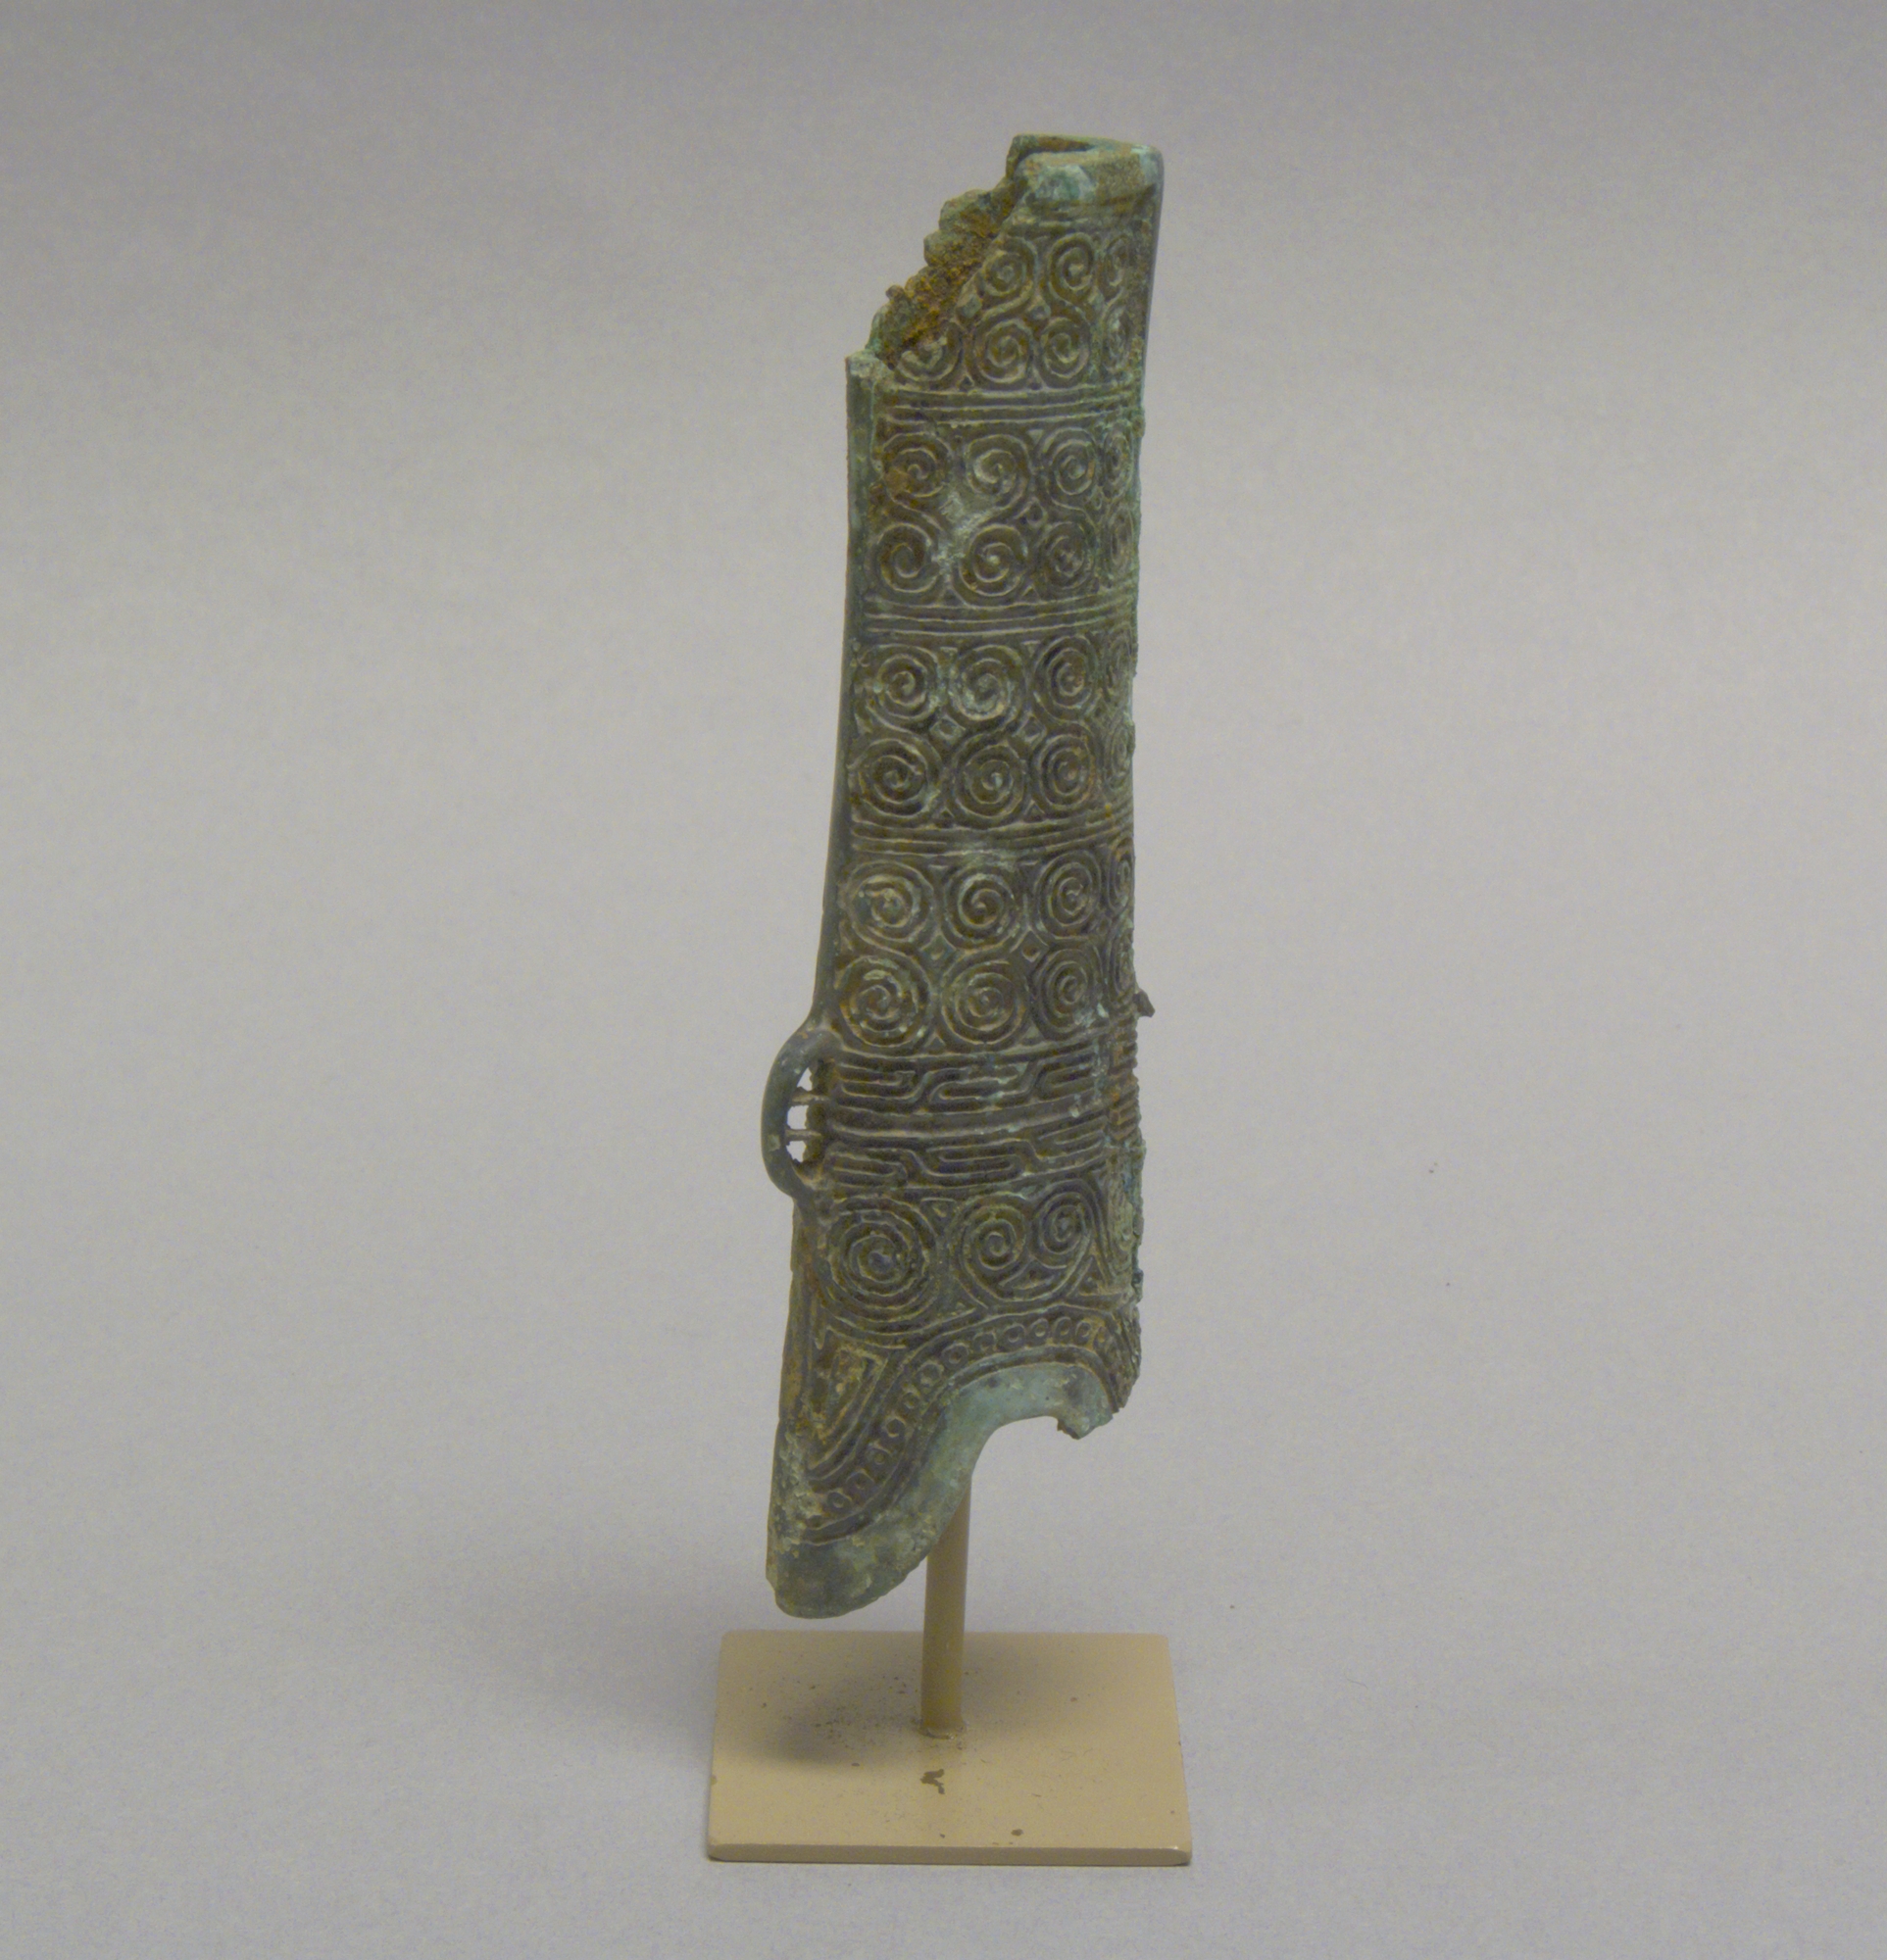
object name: fragment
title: Fragment of a Handle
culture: indonesian, javanese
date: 500 BCE-300 CE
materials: bronze